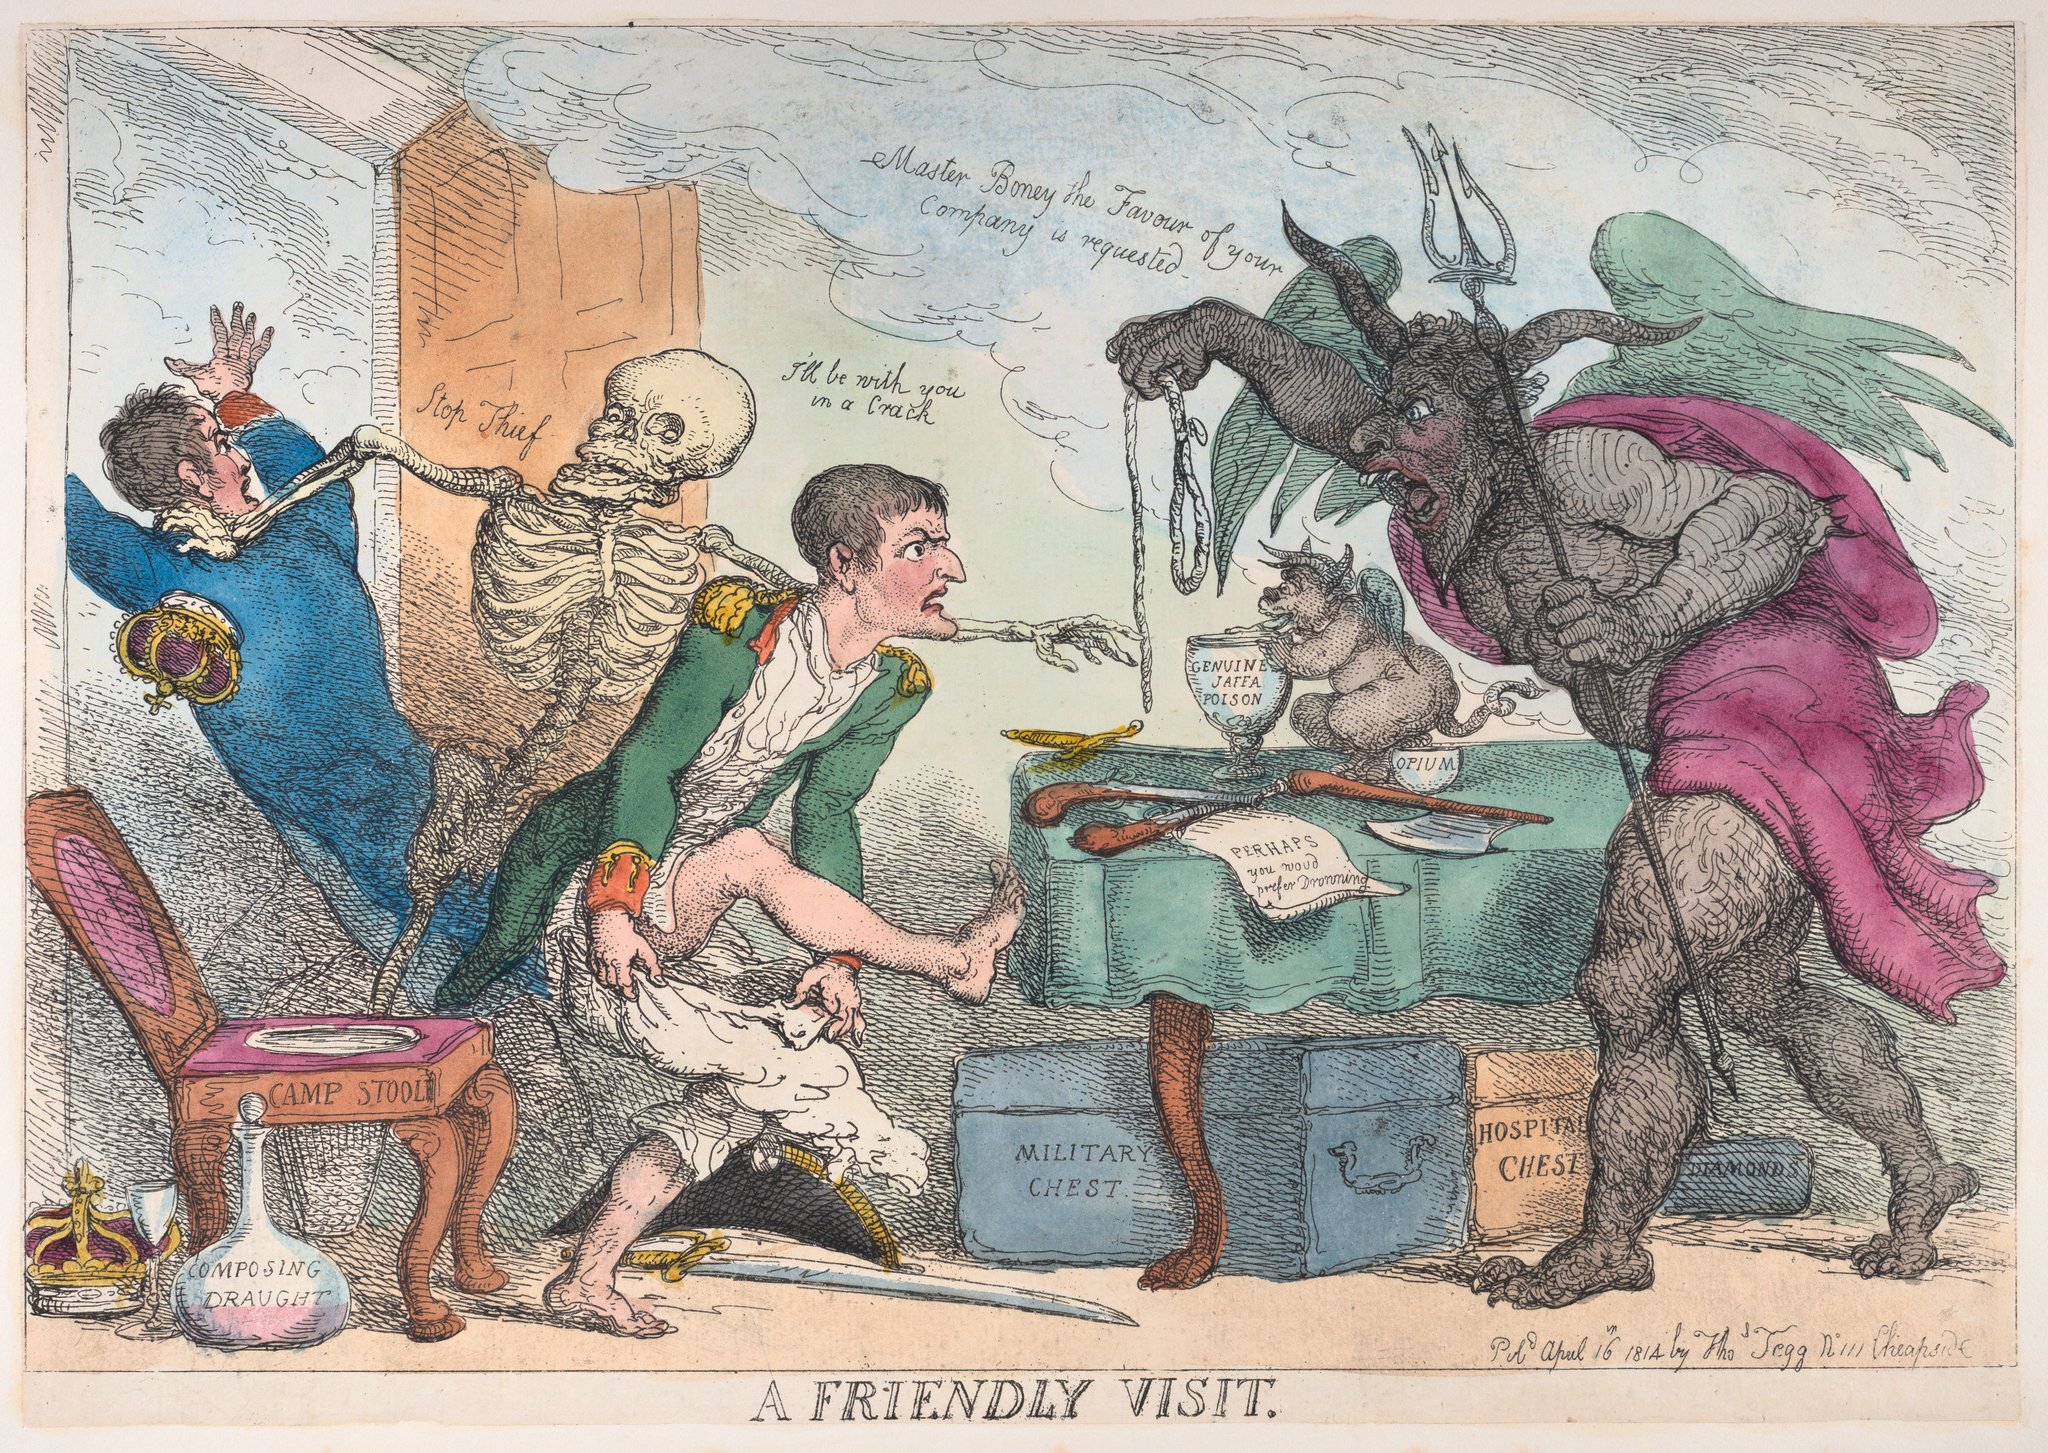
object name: print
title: A Friendly Visit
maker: thomas rowlandson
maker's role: artist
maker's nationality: british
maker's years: 1757-1827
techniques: etching, stippling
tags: satire,napoleon i,skeletons,men,devil,politics